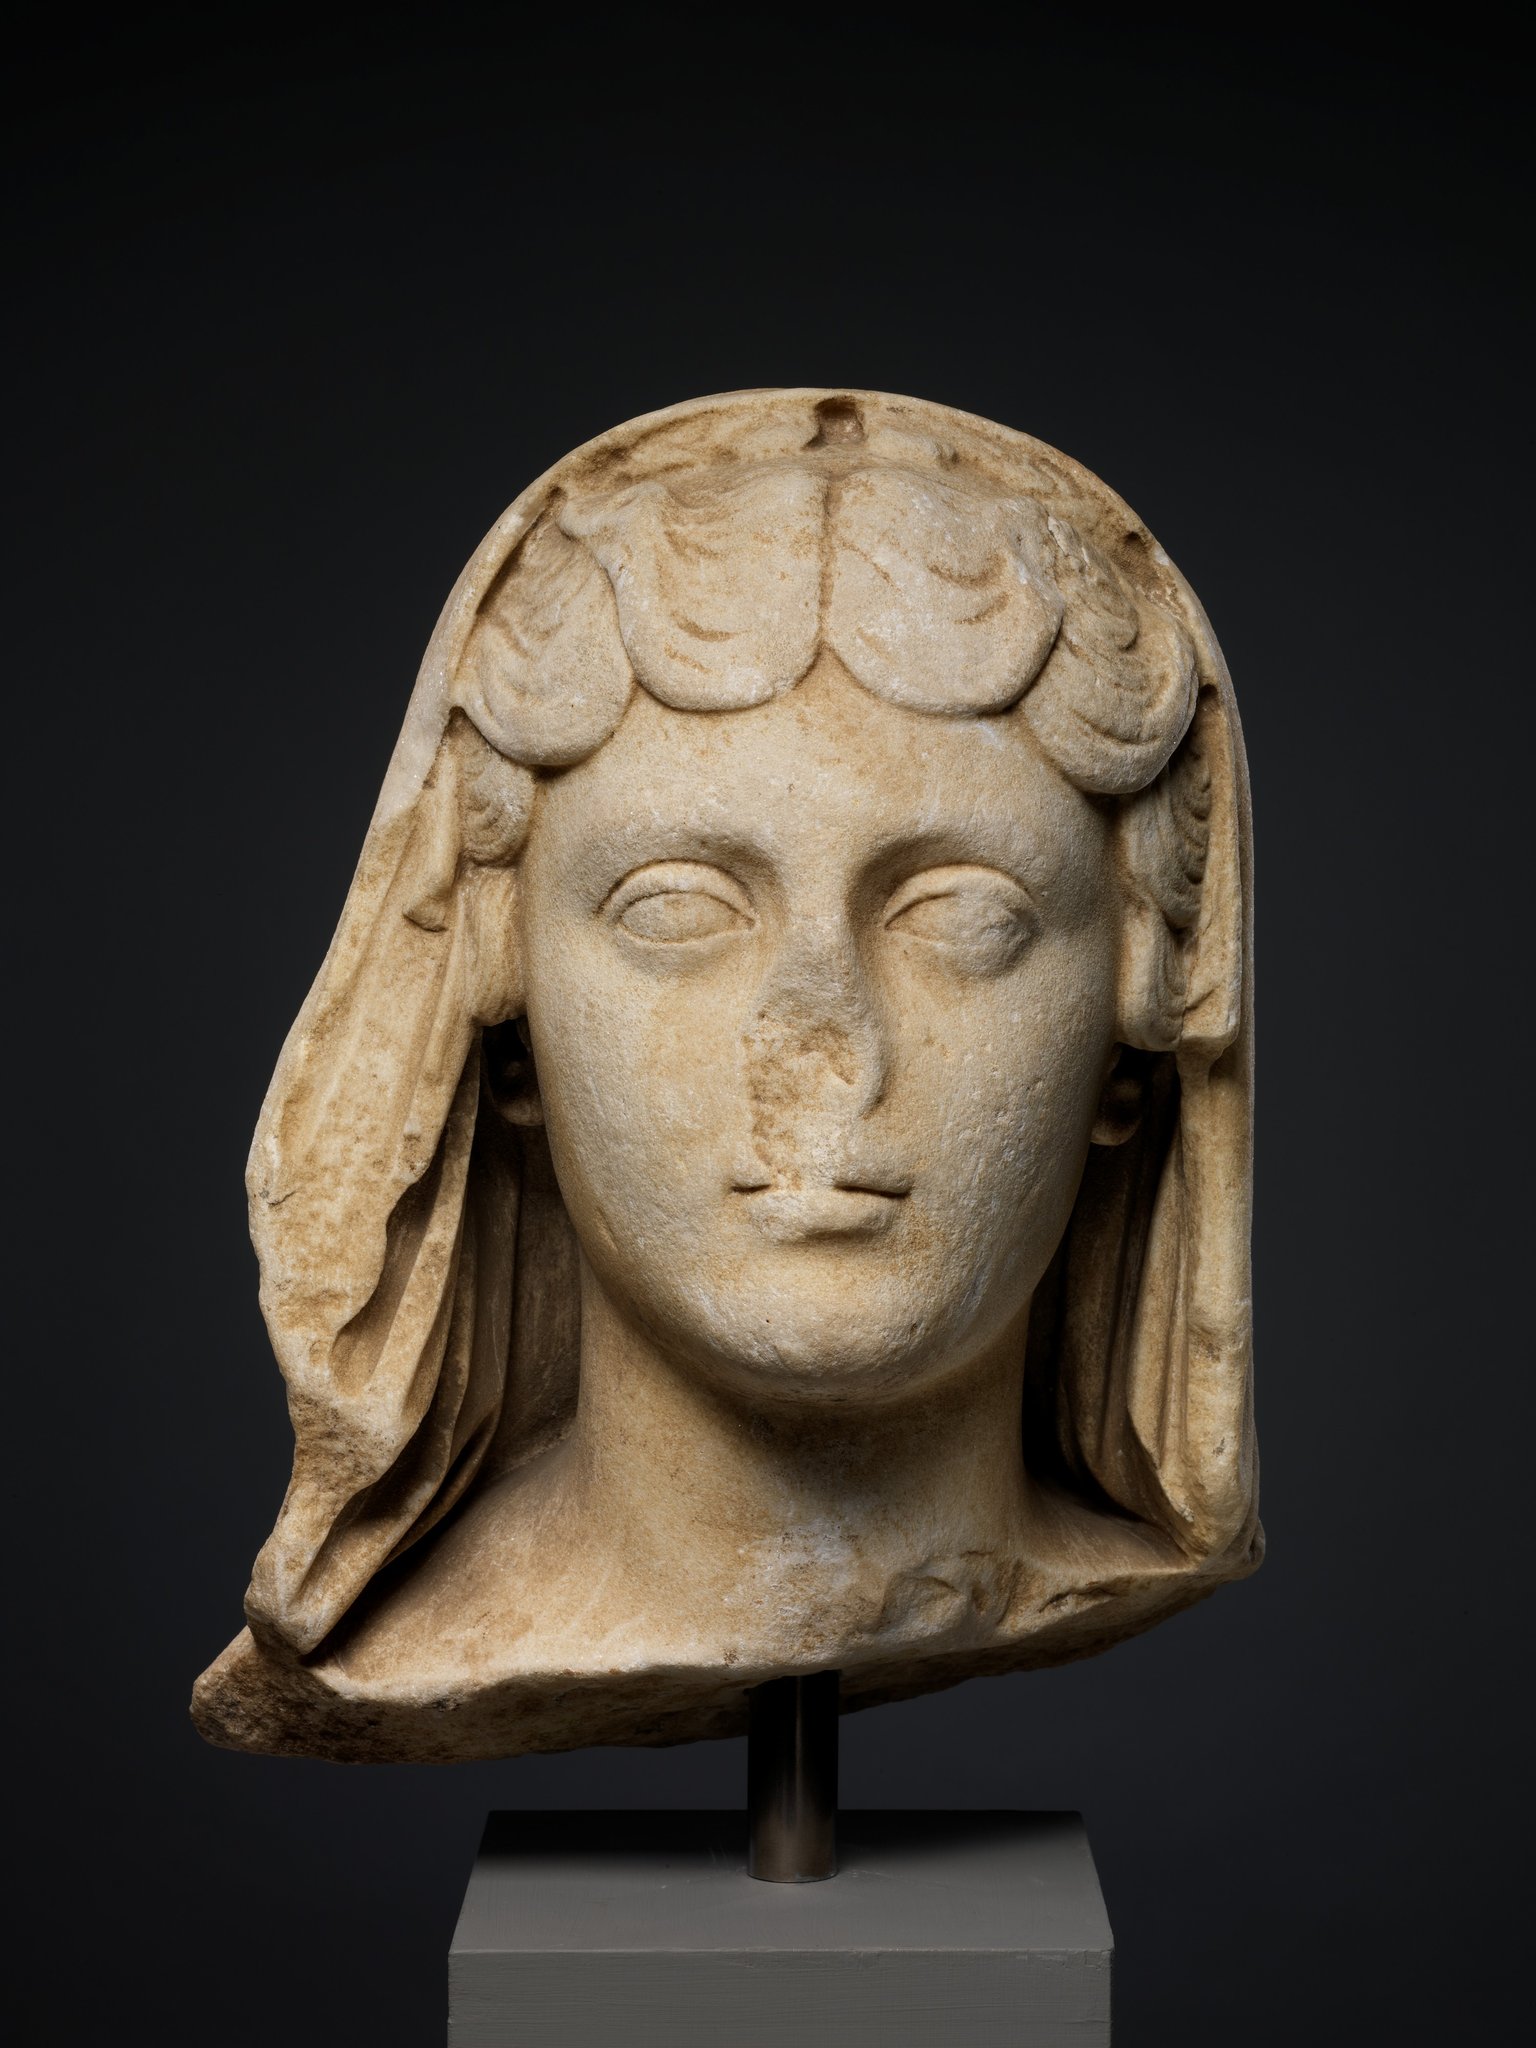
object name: portrait bust of the empress faustina, the younger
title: Marble portrait of the Empress Faustina the Younger, wife of the emperor Marcus Aurelius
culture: roman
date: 161-180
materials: marble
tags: portraits,women